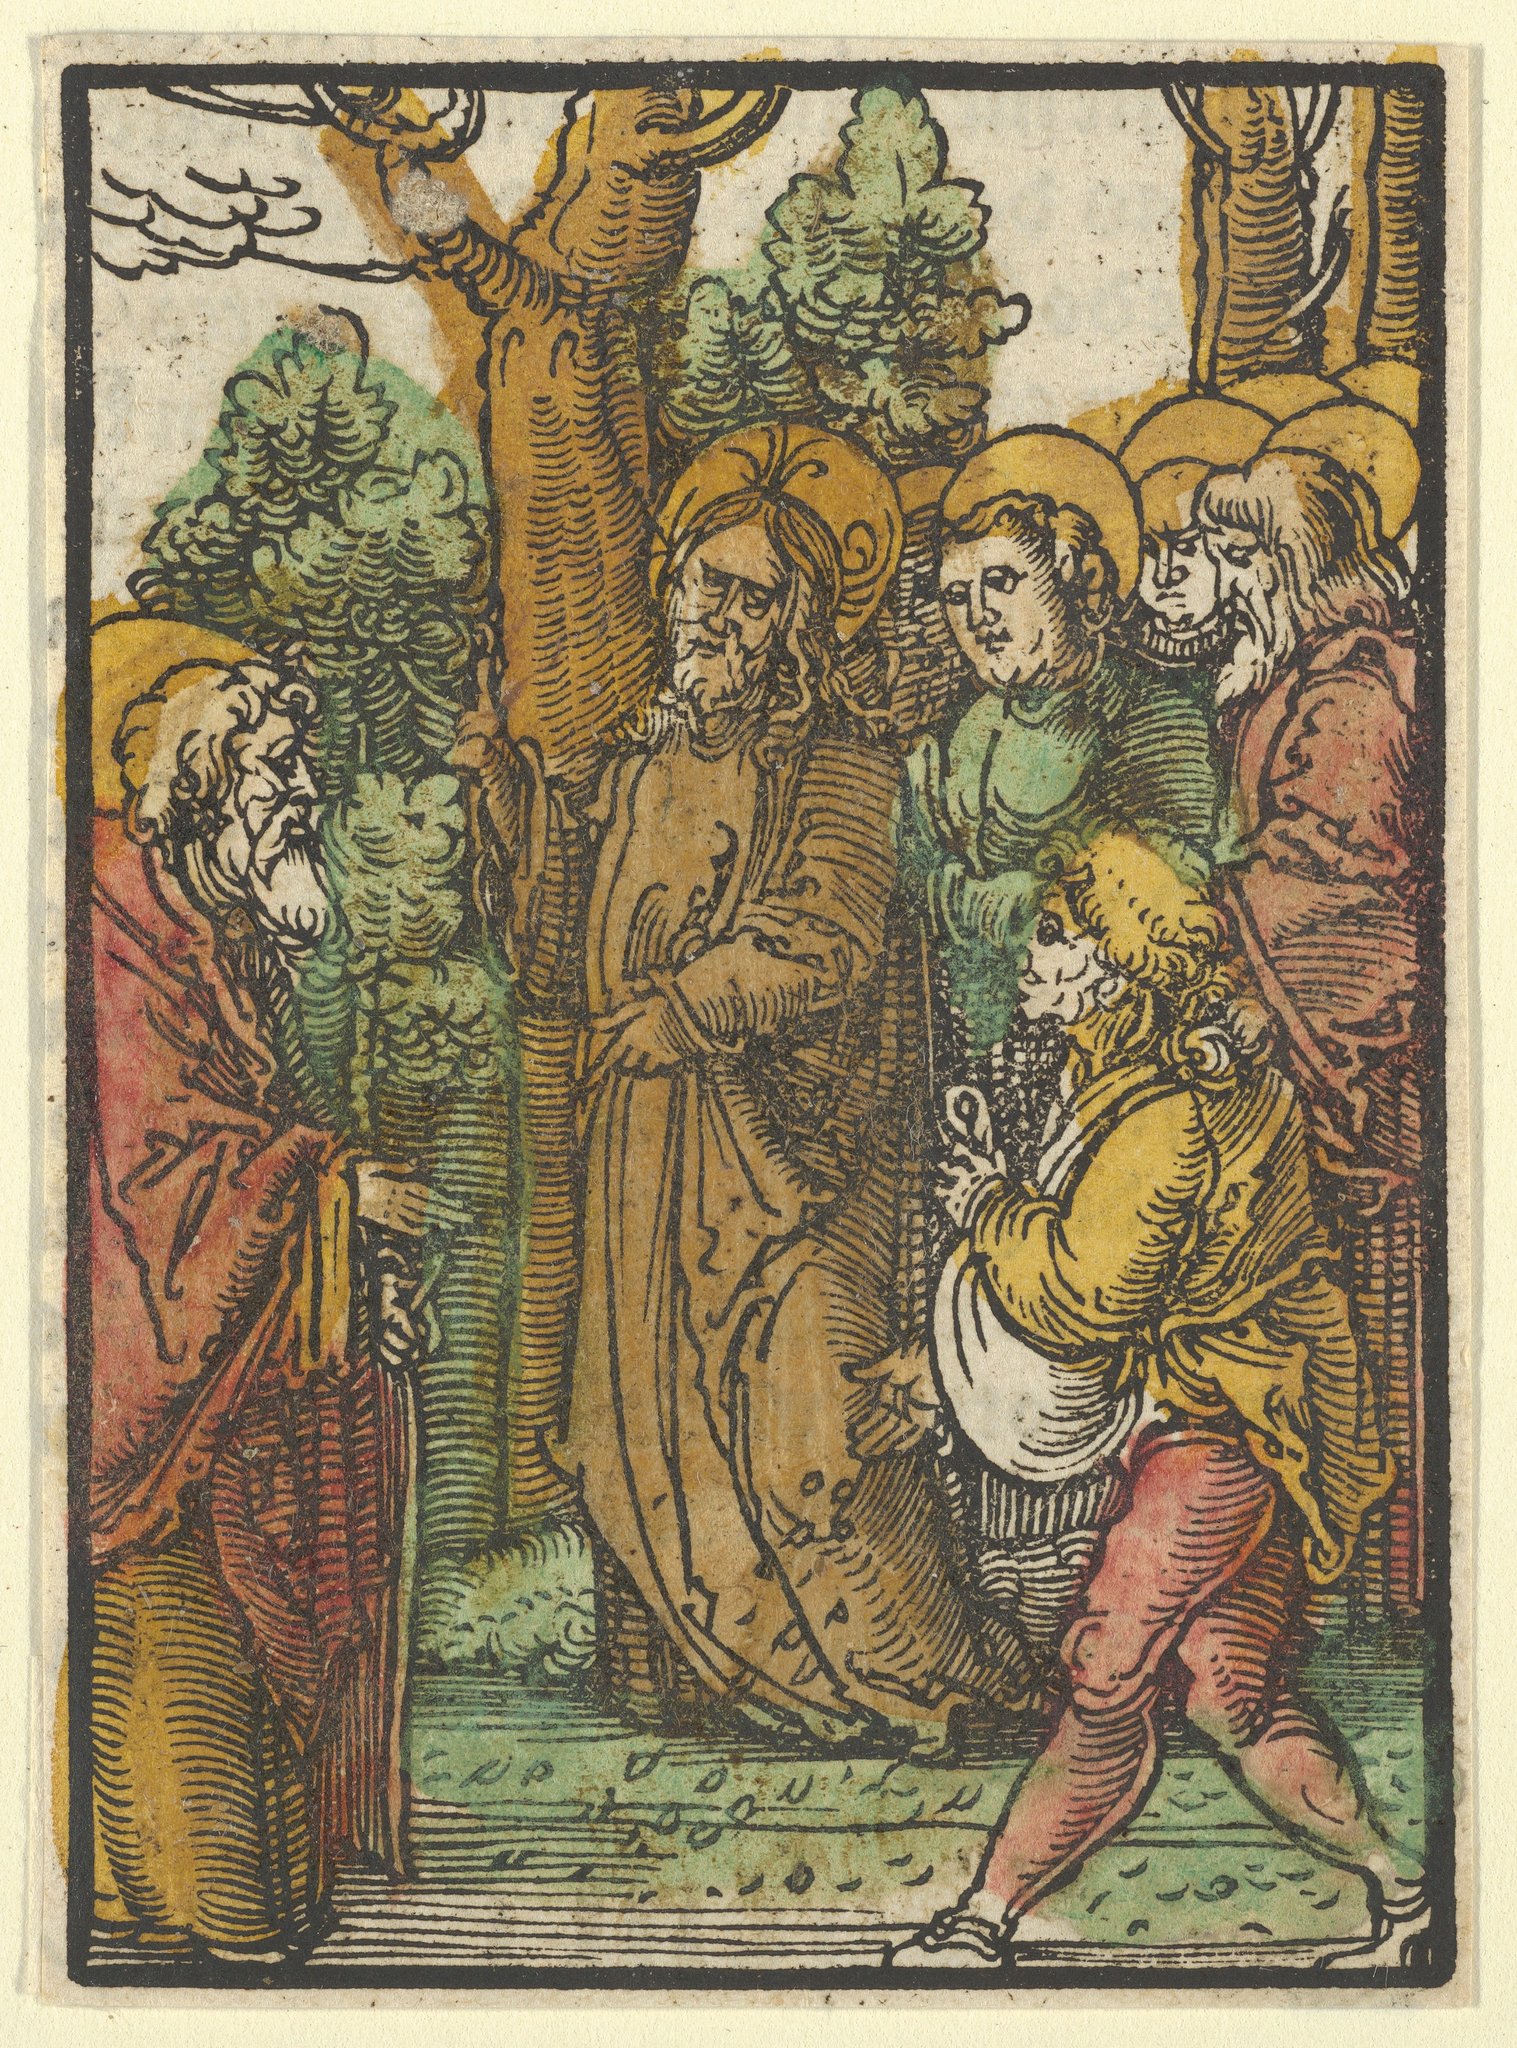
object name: print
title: The Parable of the Sower and the Weeds, from Das Plenarium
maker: hans schäufelein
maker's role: artist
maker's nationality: german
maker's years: 1480-1540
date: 1517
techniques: hand coloring, woodcut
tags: men,jesus,saints